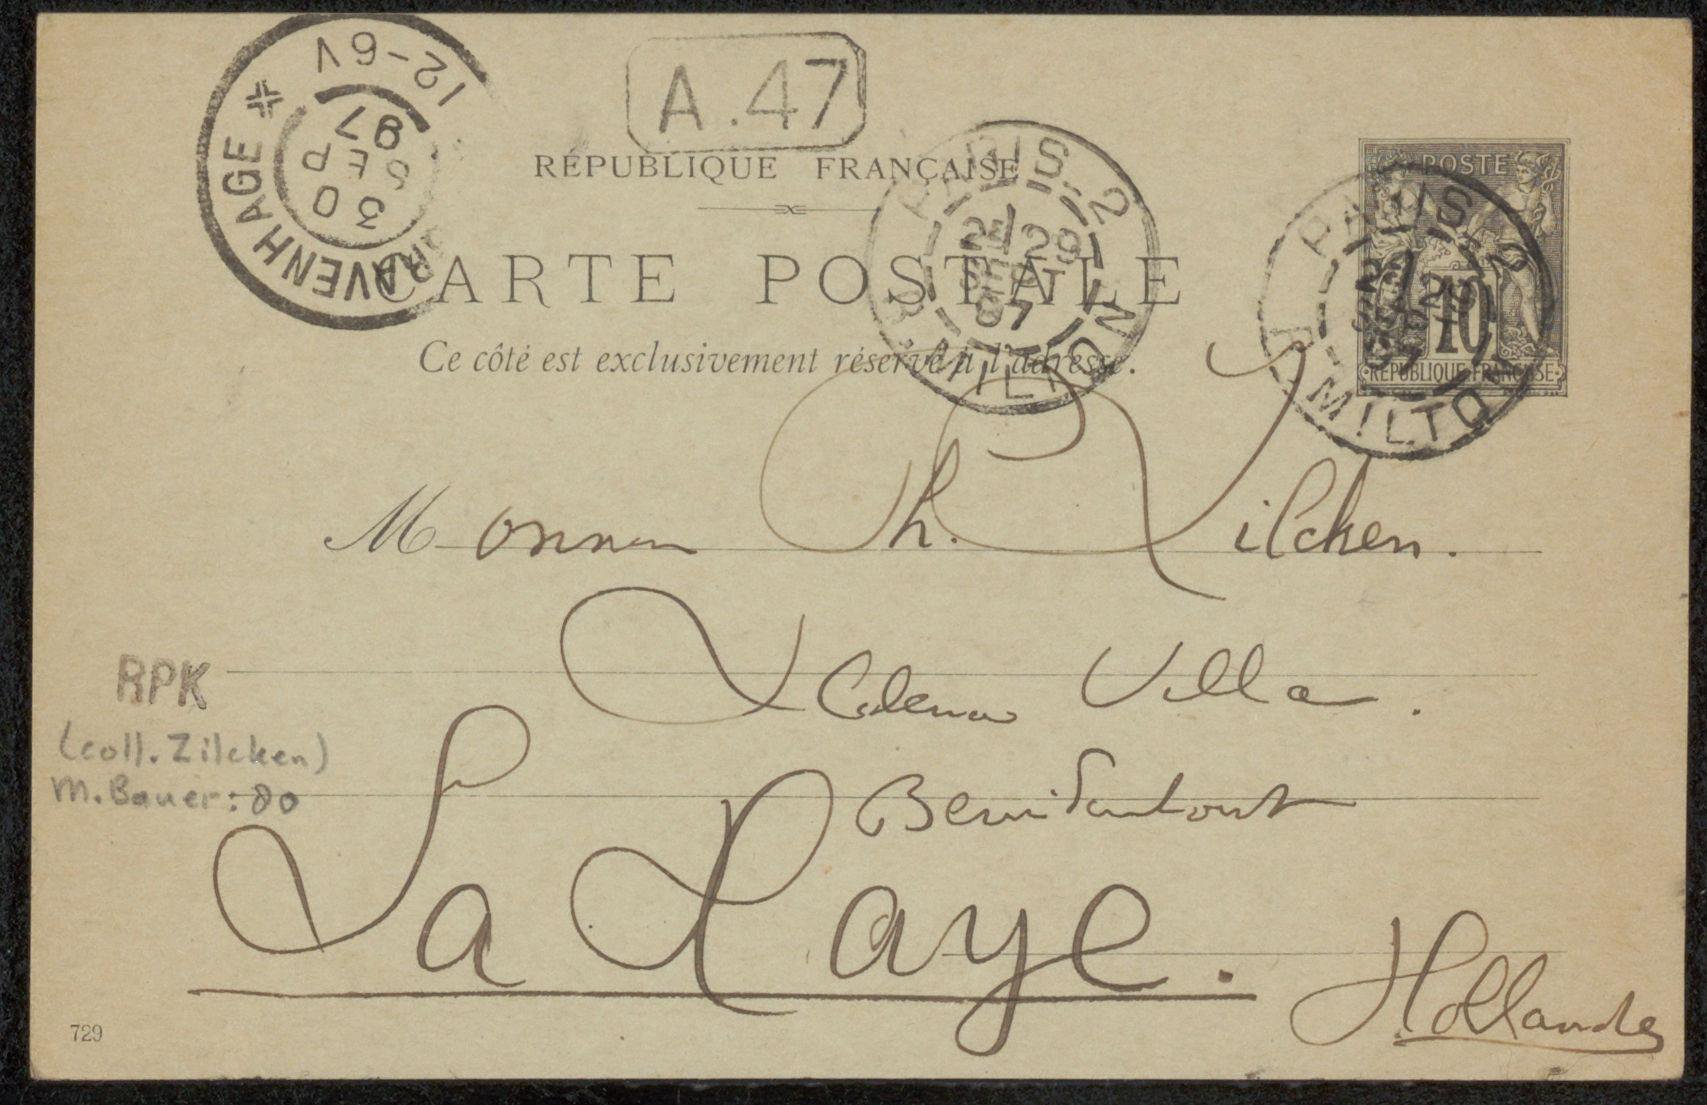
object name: postcard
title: Briefkaart aan Philip Zilcken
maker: marius bauer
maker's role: draughtsman, print maker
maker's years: 1867-1932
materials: cardboard, ink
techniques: pen, writing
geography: paris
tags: painter, philip zilcken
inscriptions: collector's mark: ‘RPK’